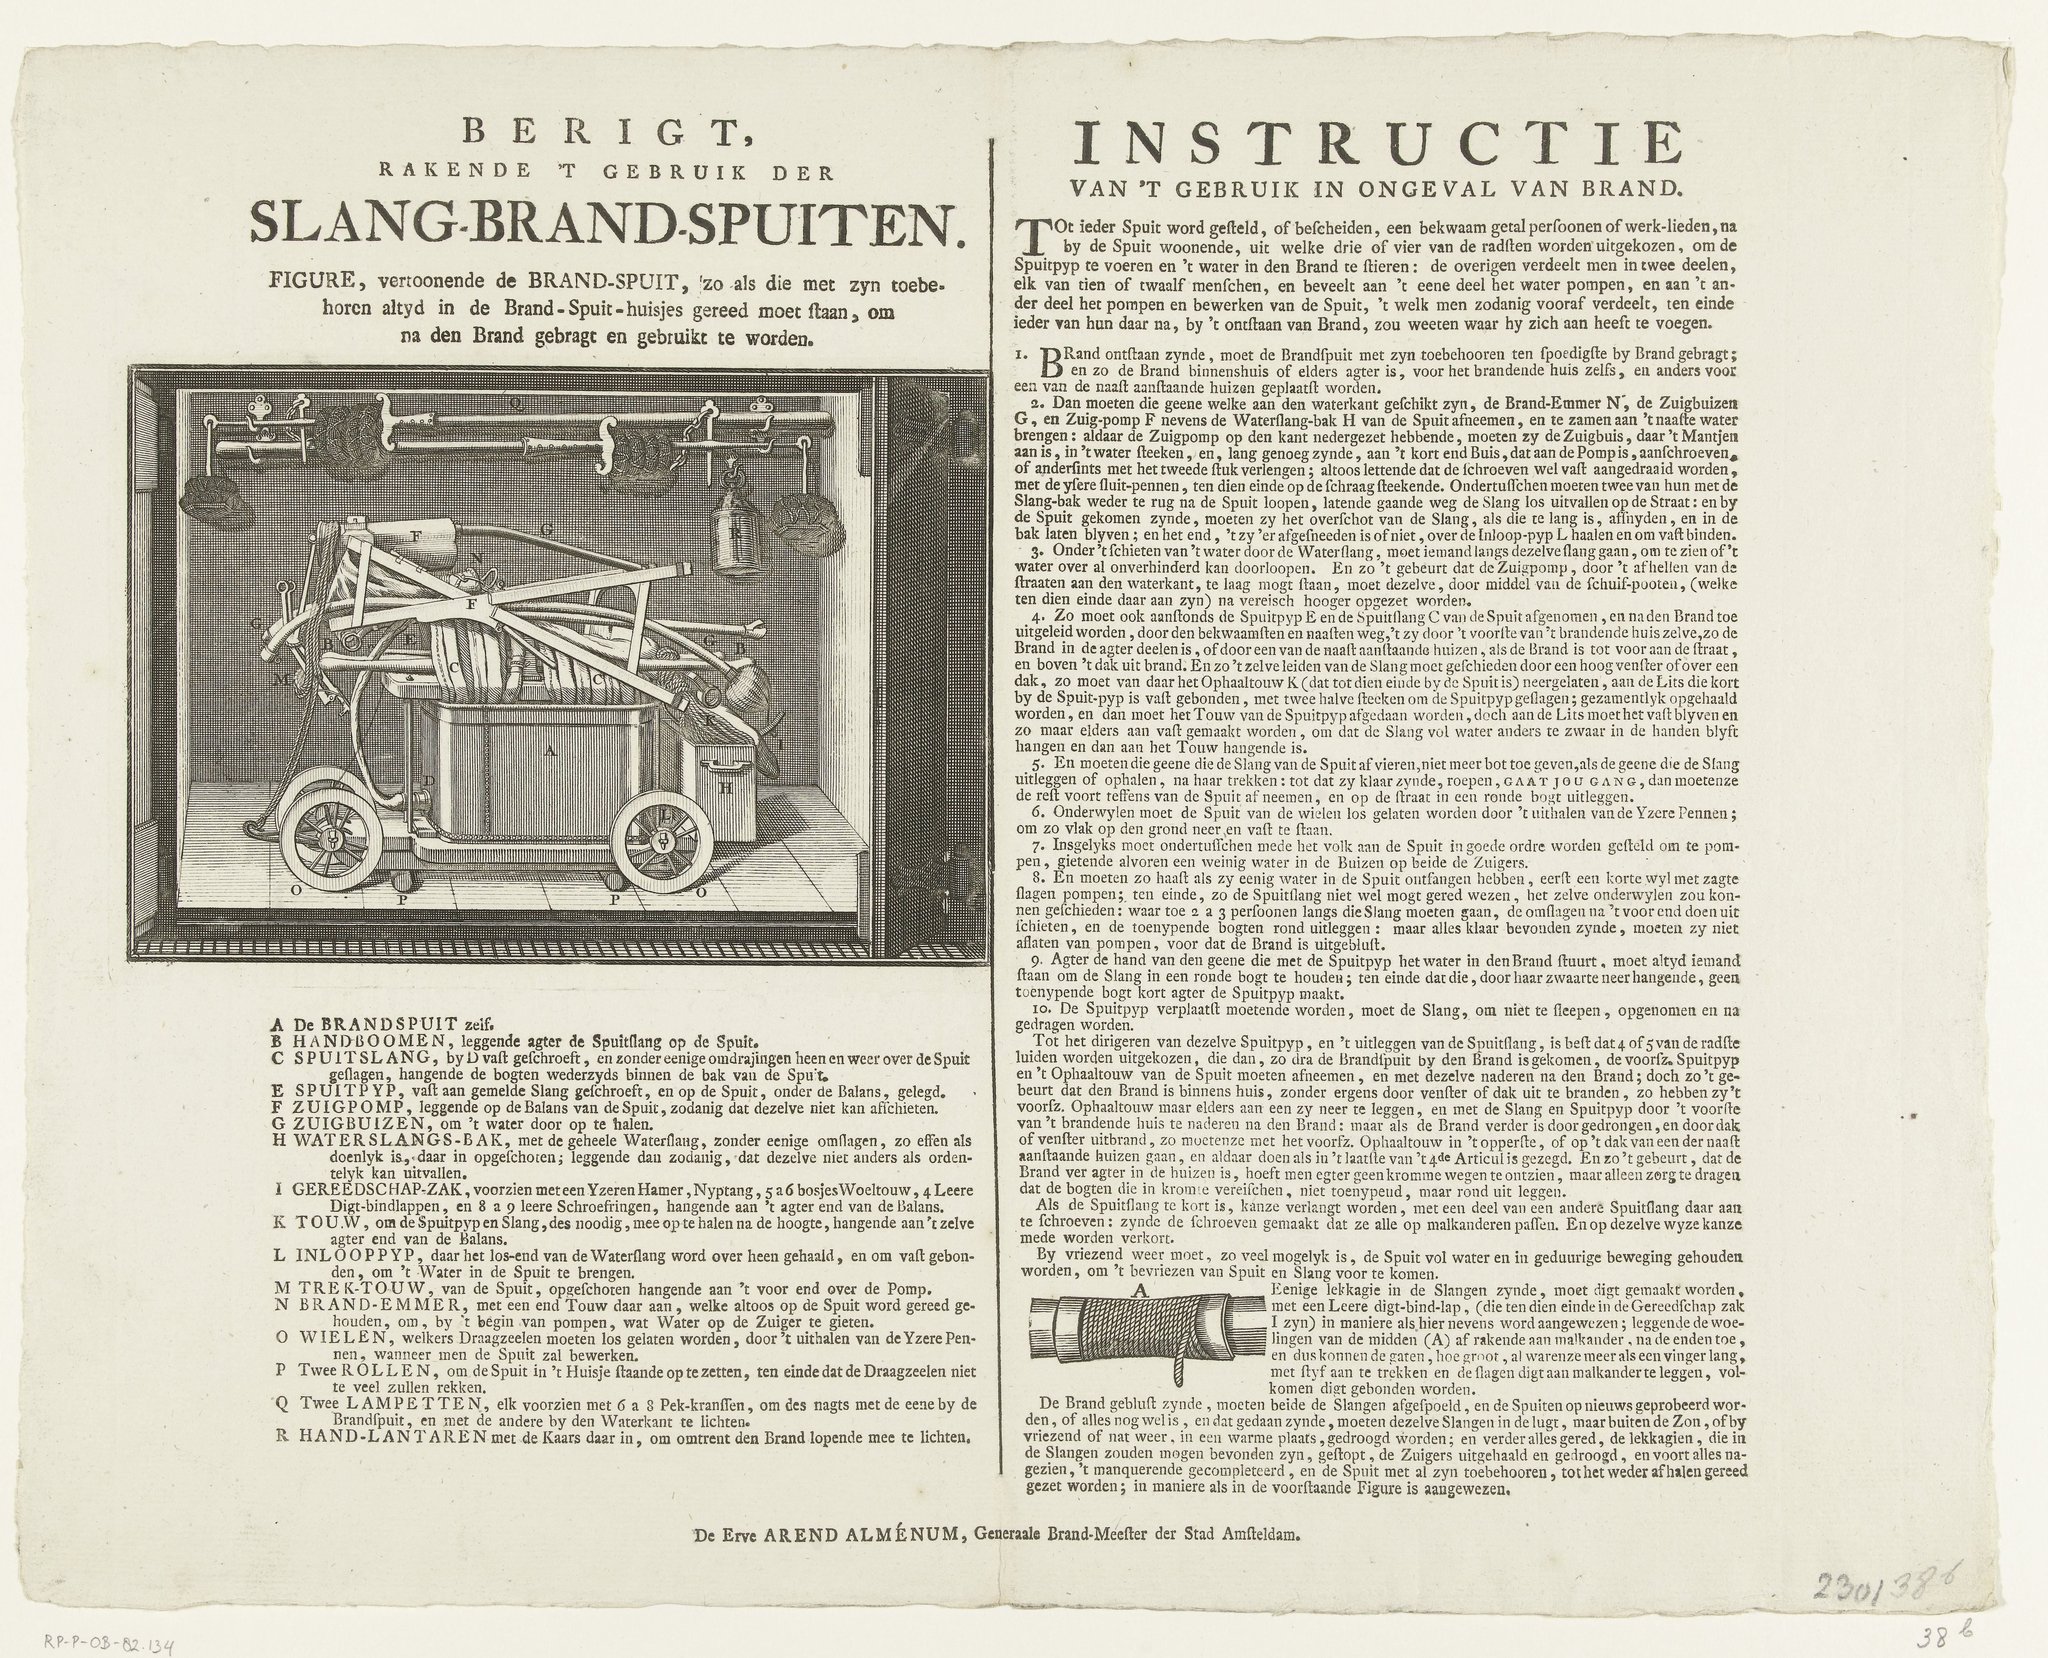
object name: print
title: Berigt, rakende 't gebruik der Slang-brand-spuiten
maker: Anonymous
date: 1784-1830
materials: paper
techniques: etching, letterpress printing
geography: amsterdam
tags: painter, print maker, draughtsman, jan van der heyden, fire-extinguishing equipment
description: Blad met een instructie over het correcte gebruik en bewaring van de slangbrandspuiten, ca. 1800. Links een voorstelling hoe de slangbrandspuit en pomp in het brandspuithuisje opgeborgen dienen te worden na gebruik, met de legenda A-R. Rechts de instructie voor gebruik in het geval van brand en een plaatje hoe een lekkage in een slang gerepareerd dient te worden. Behoort tot de bijprenten bij het Brandspuitenboek van Jan van der Heyden.